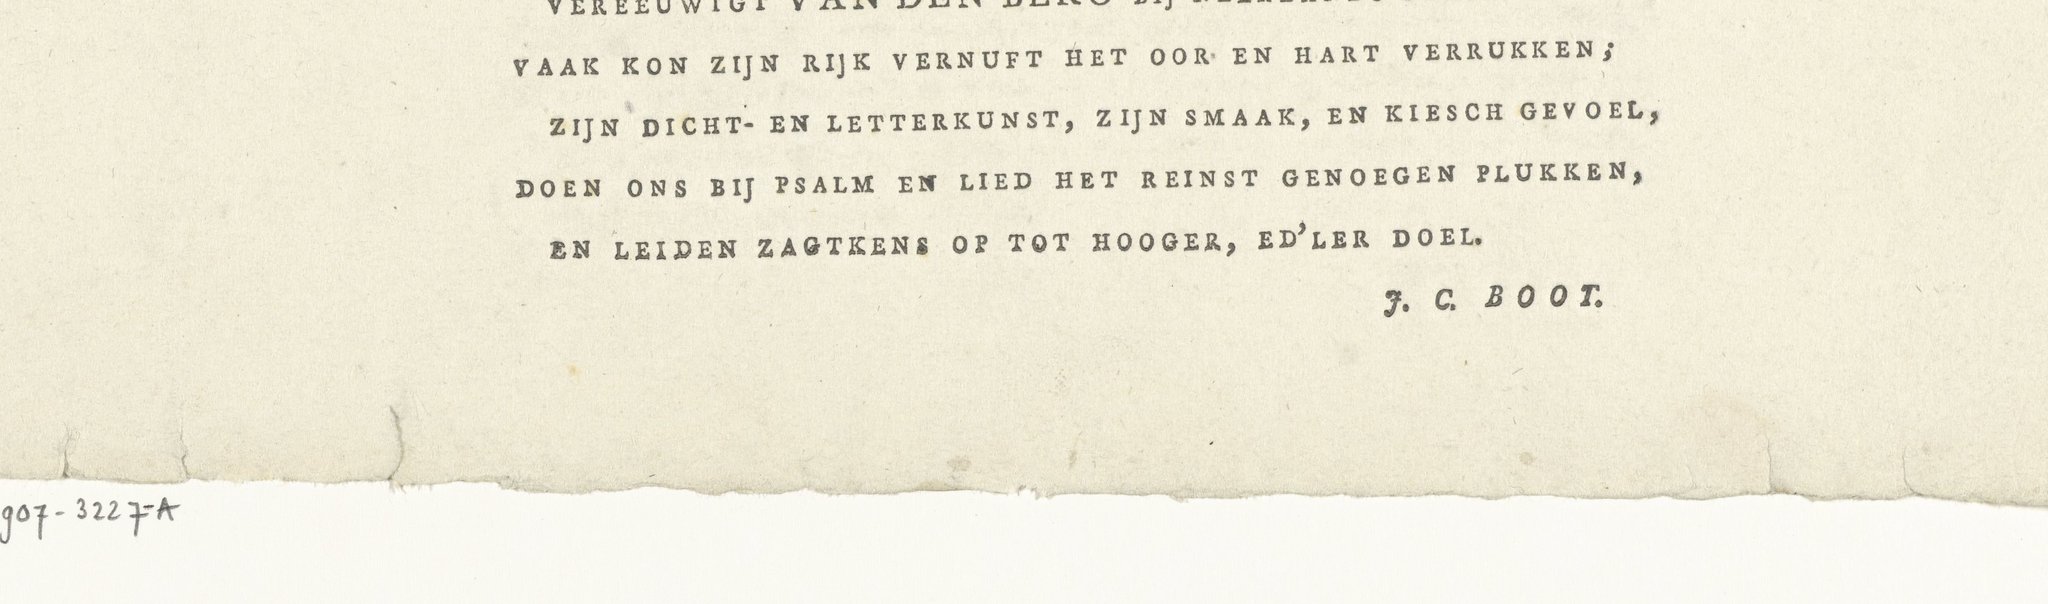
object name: text sheet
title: Tekstblad behorende bij het grafmonument voor Ahasverus van den Berg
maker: johannes cornelis boot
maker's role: dichter, schrijver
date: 1807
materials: paper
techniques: letterpress printing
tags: ahasverus van den berg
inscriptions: collector's mark: Lugt 2228